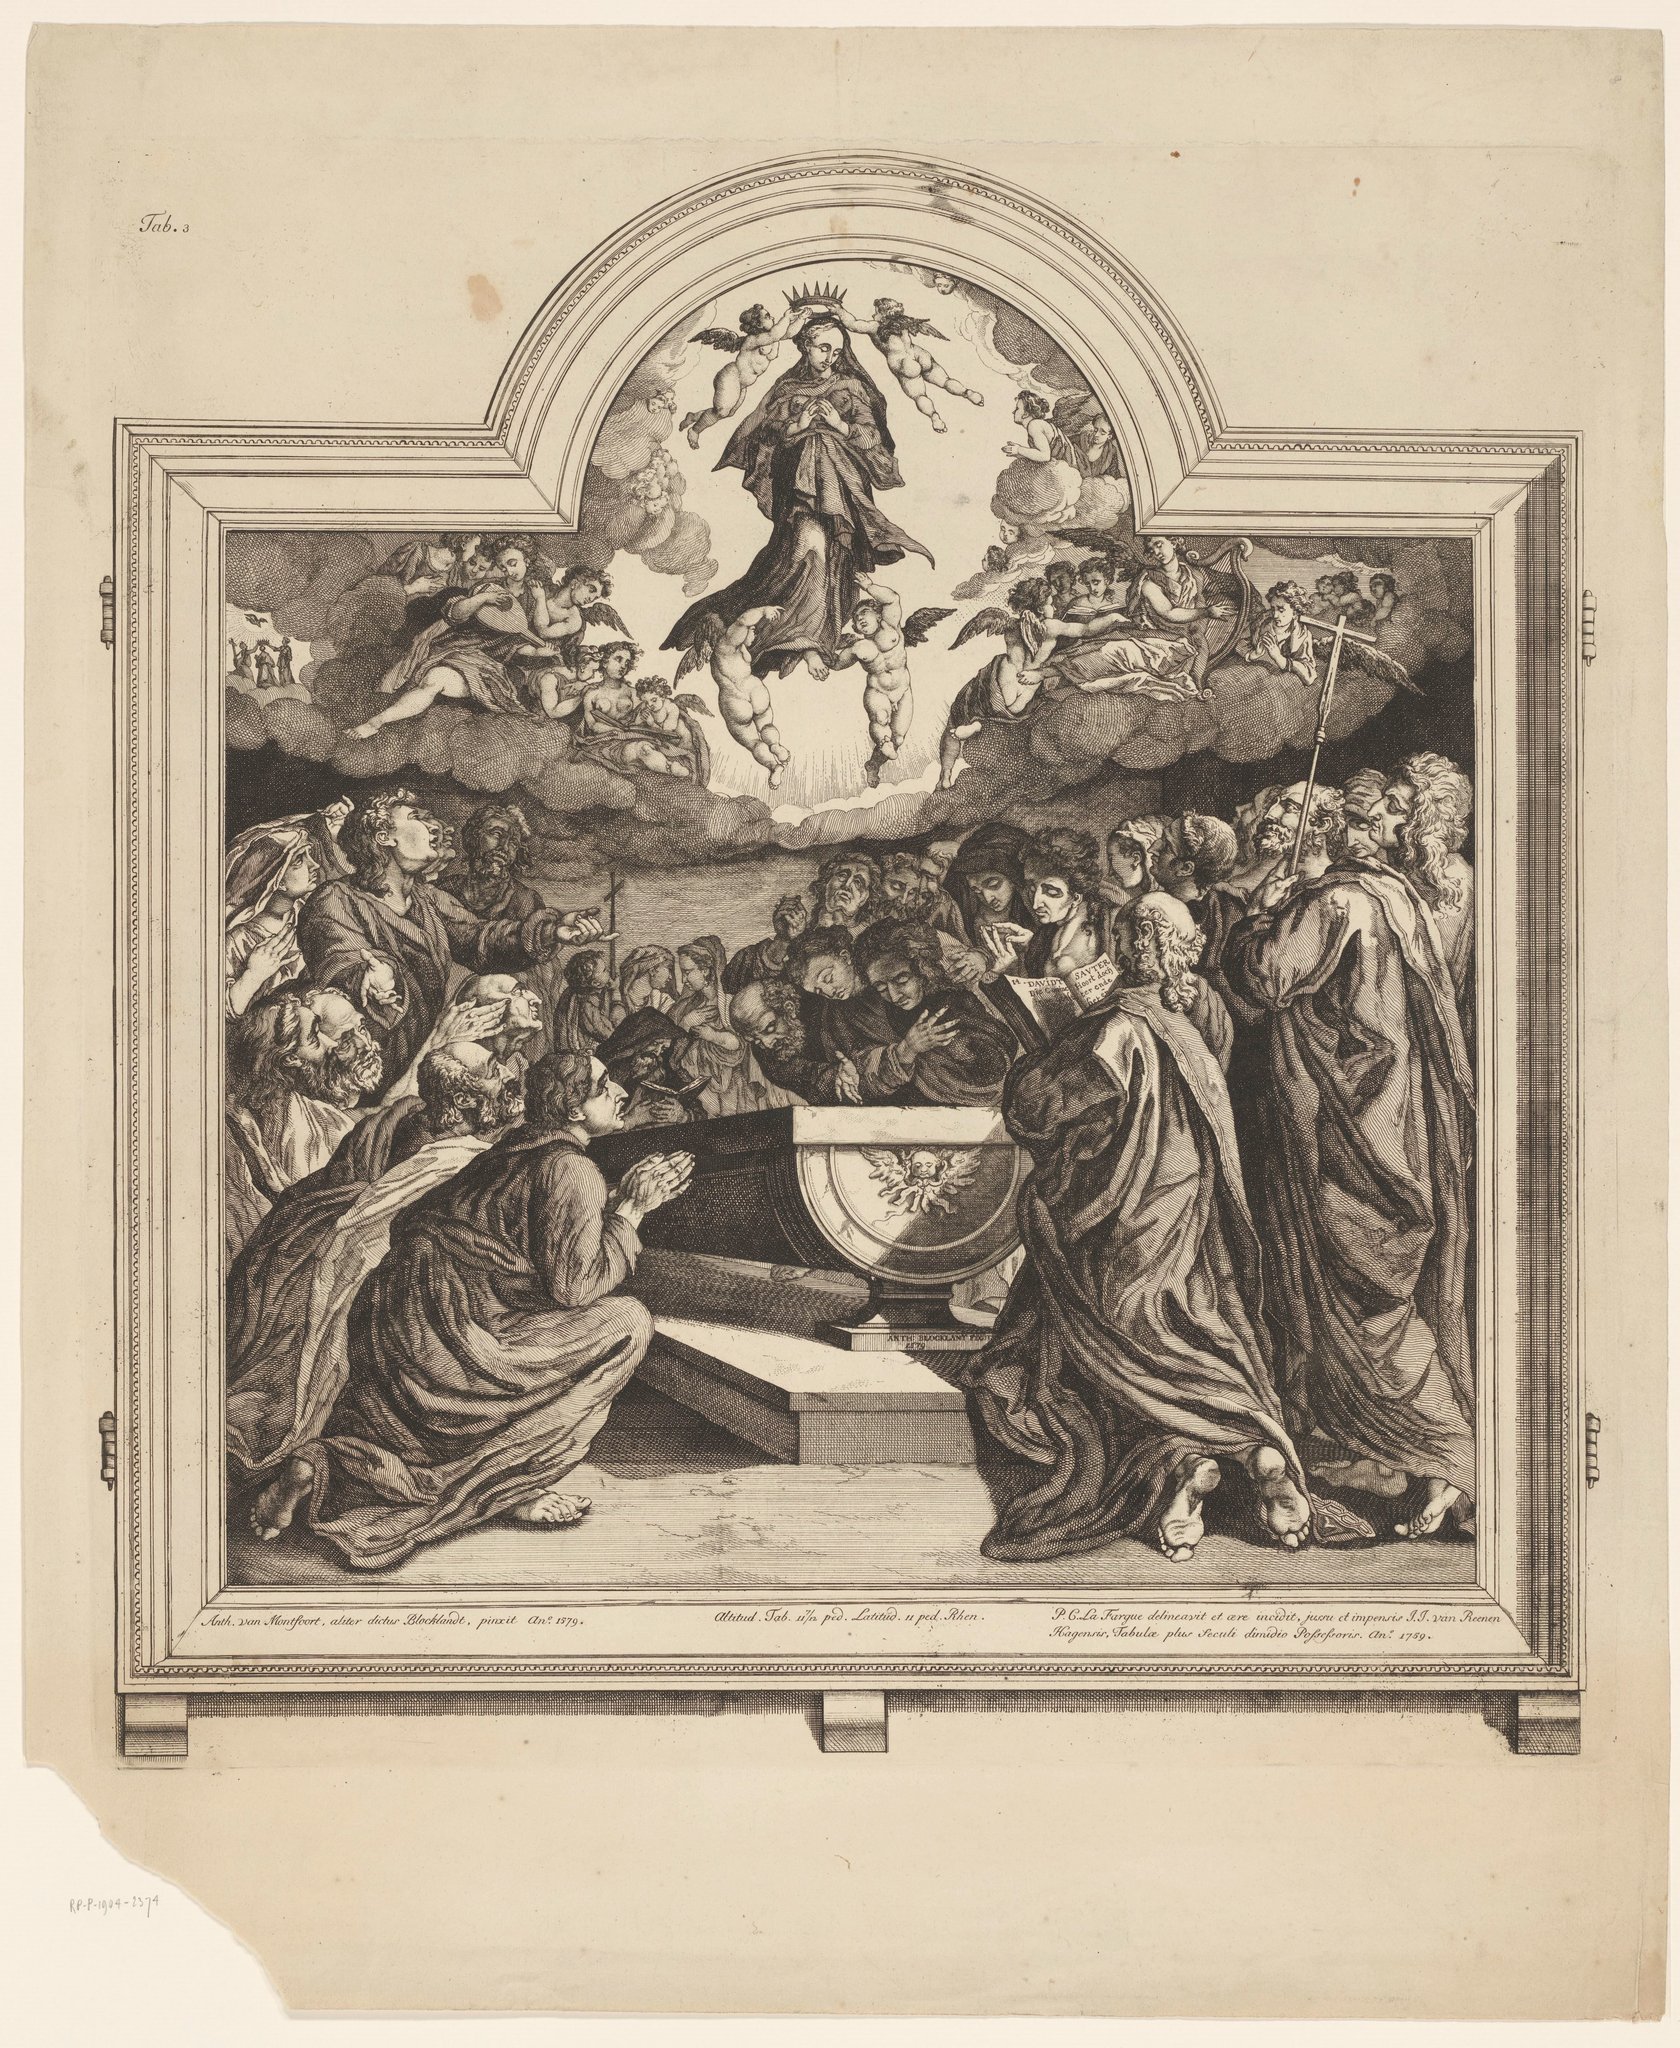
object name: print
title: Hemelvaart van Maria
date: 1759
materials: paper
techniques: engraving, etching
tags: coronation of mary by one or more angels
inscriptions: collector's mark: Lugt 2228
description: Onderdeel van een prent naar het drieluik naar Anthony van Blocklandt. Het middenpaneel vertoont de Hemelvaart van Maria, het linkerpaneel de Aanbidding door de herders en het rechterpaneel de Annunciatie. De achterzijden van de zijpanelen vertonen links Maria met kind en rechts de opdrachtgever met de apostel Andreas en de aartsengel Michael.